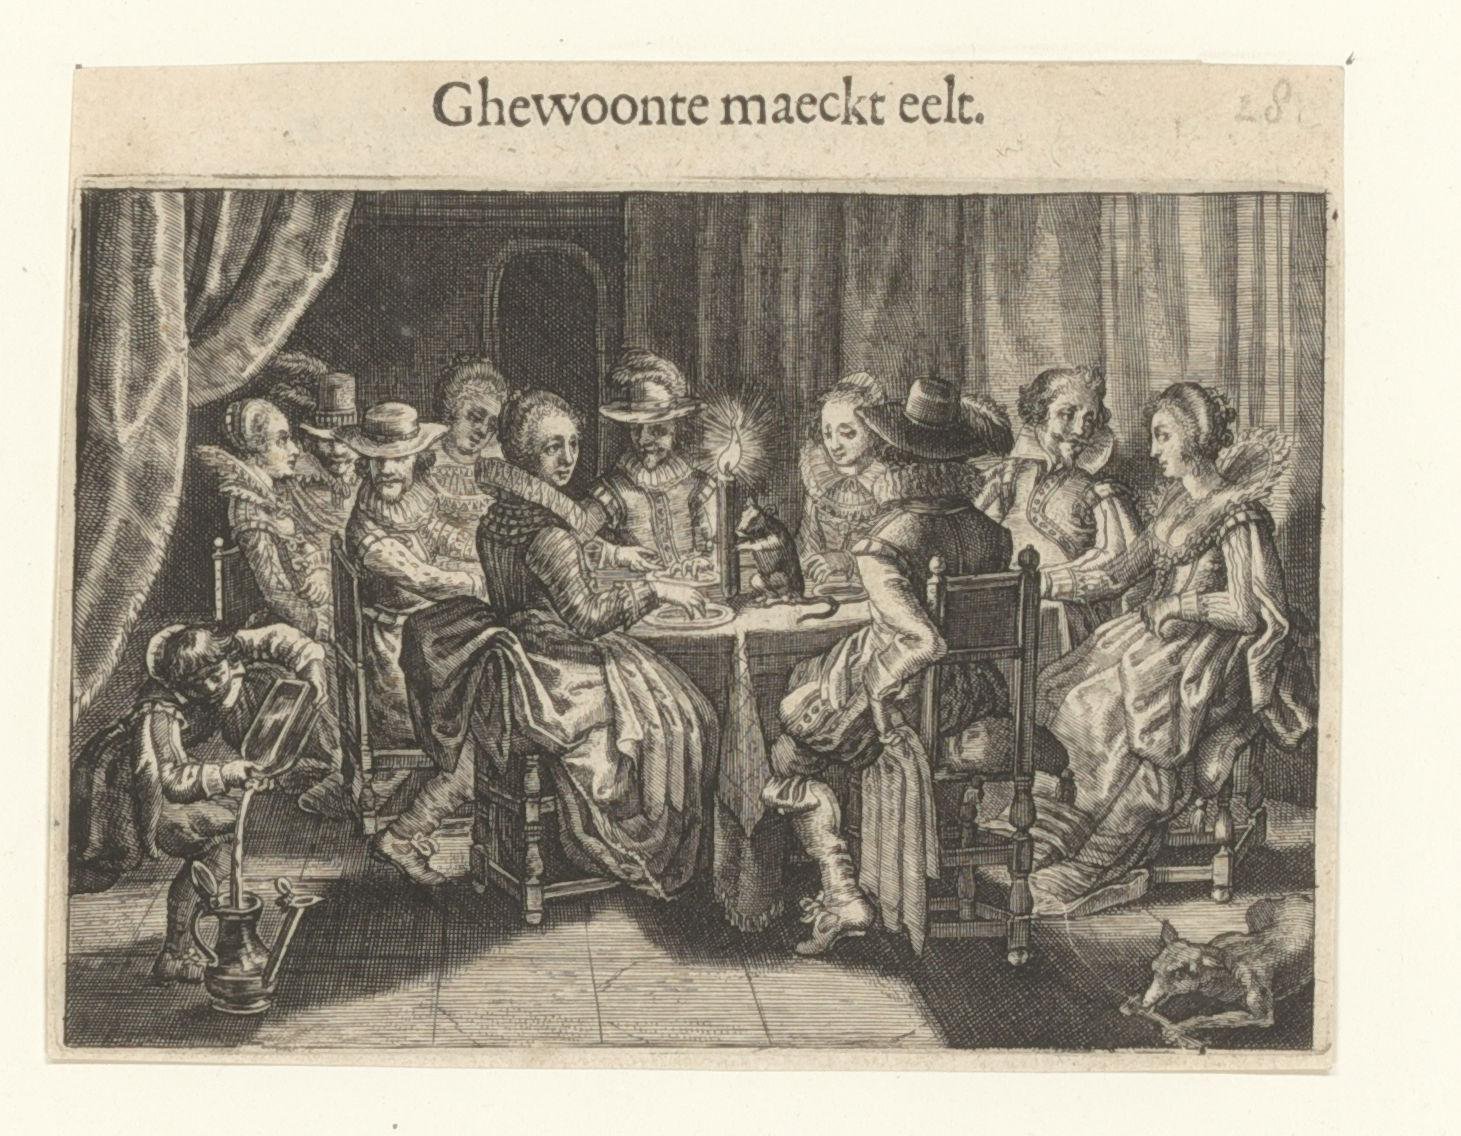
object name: print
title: Gezelschap dineert bij kaarslicht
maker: Anonymous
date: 1624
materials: paper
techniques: engraving, letterpress printing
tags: rodents: rat, jar, jug (used as drinking-vessel), proverbs, sayings, etc., container of glass: bottle, jar, vase, candle (+ kindling a light; lit, burning light, lamp, candle), banquet of elegant company, manservant, footman, dog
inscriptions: collector's mark: Lugt 1641, stamp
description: Prent uit: Brune, Johan de. Zinne-werck, Voor-ghesyelt in Beelden, Ghedichten, ende breeder uyt-legginghen (...). Amsterdam: Evertsen Kloppenburch, 1624. Prent ook gebruikt in latere edities (1636 en 1661).